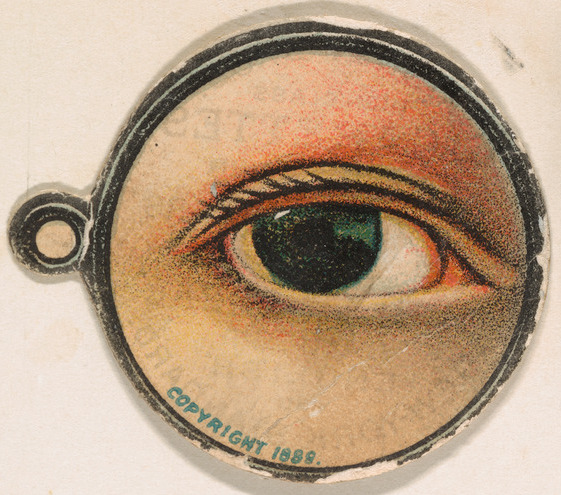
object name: print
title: Monocle and Eye (dark blue), from Jocular Ocular series (N221) issued by Kinney Bros.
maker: kinney brothers tobacco company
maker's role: publisher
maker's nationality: american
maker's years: 1869-2011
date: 1889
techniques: color lithograph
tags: eyes